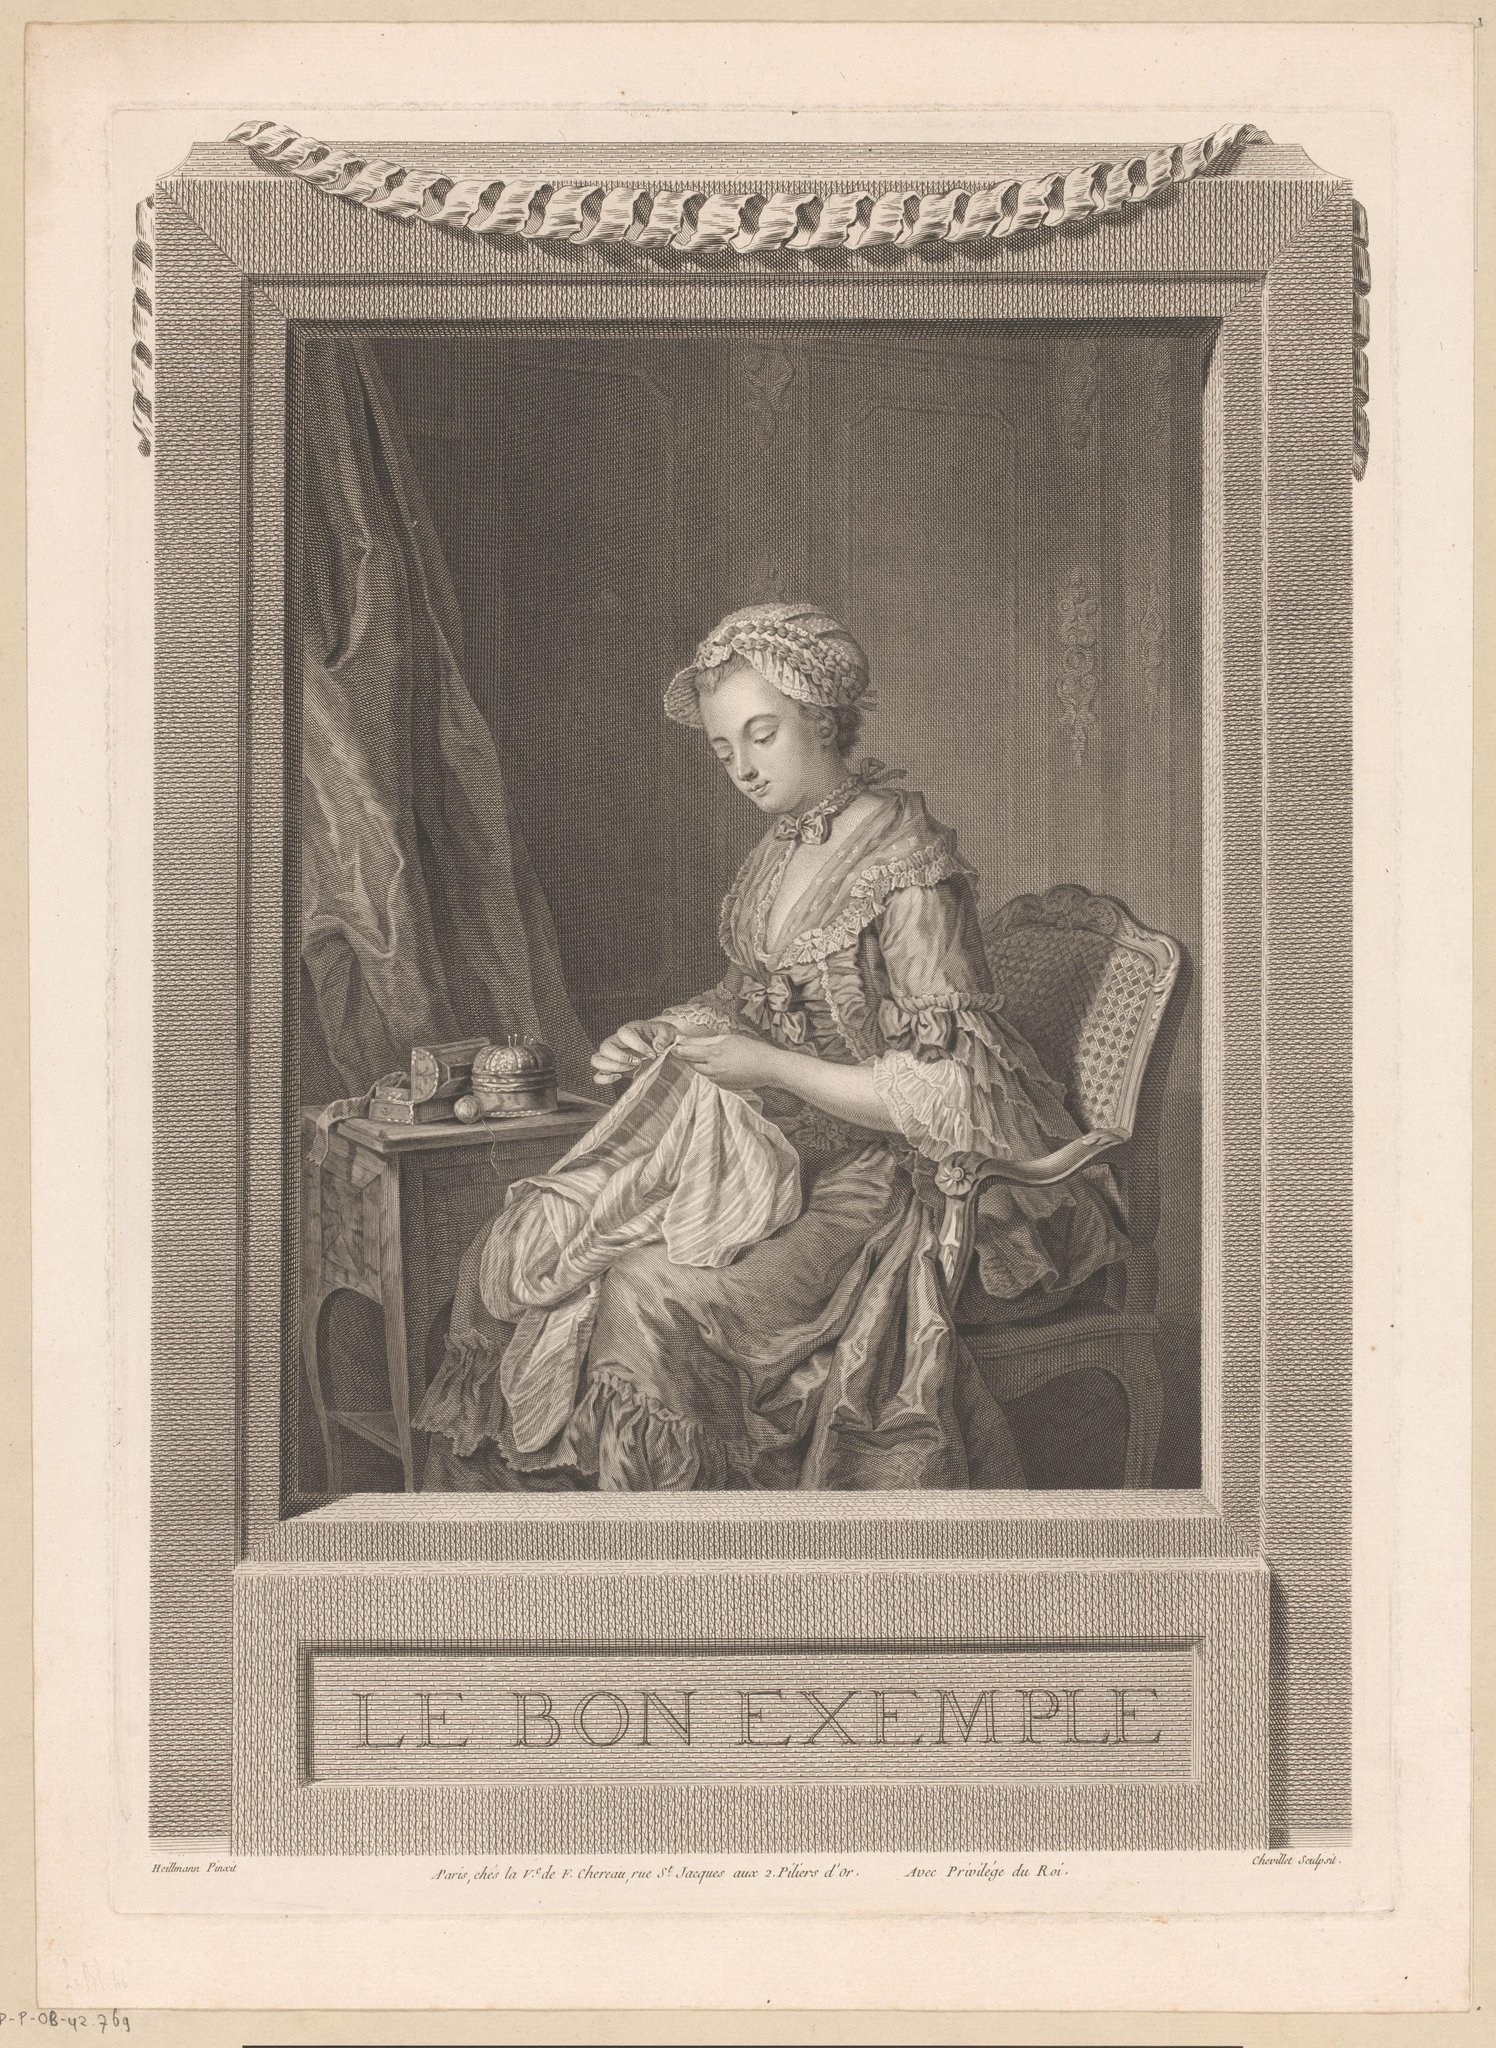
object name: print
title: Le bon exemple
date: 1762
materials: paper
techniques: engraving, etching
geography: paris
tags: head-gear, sewing box, sewing